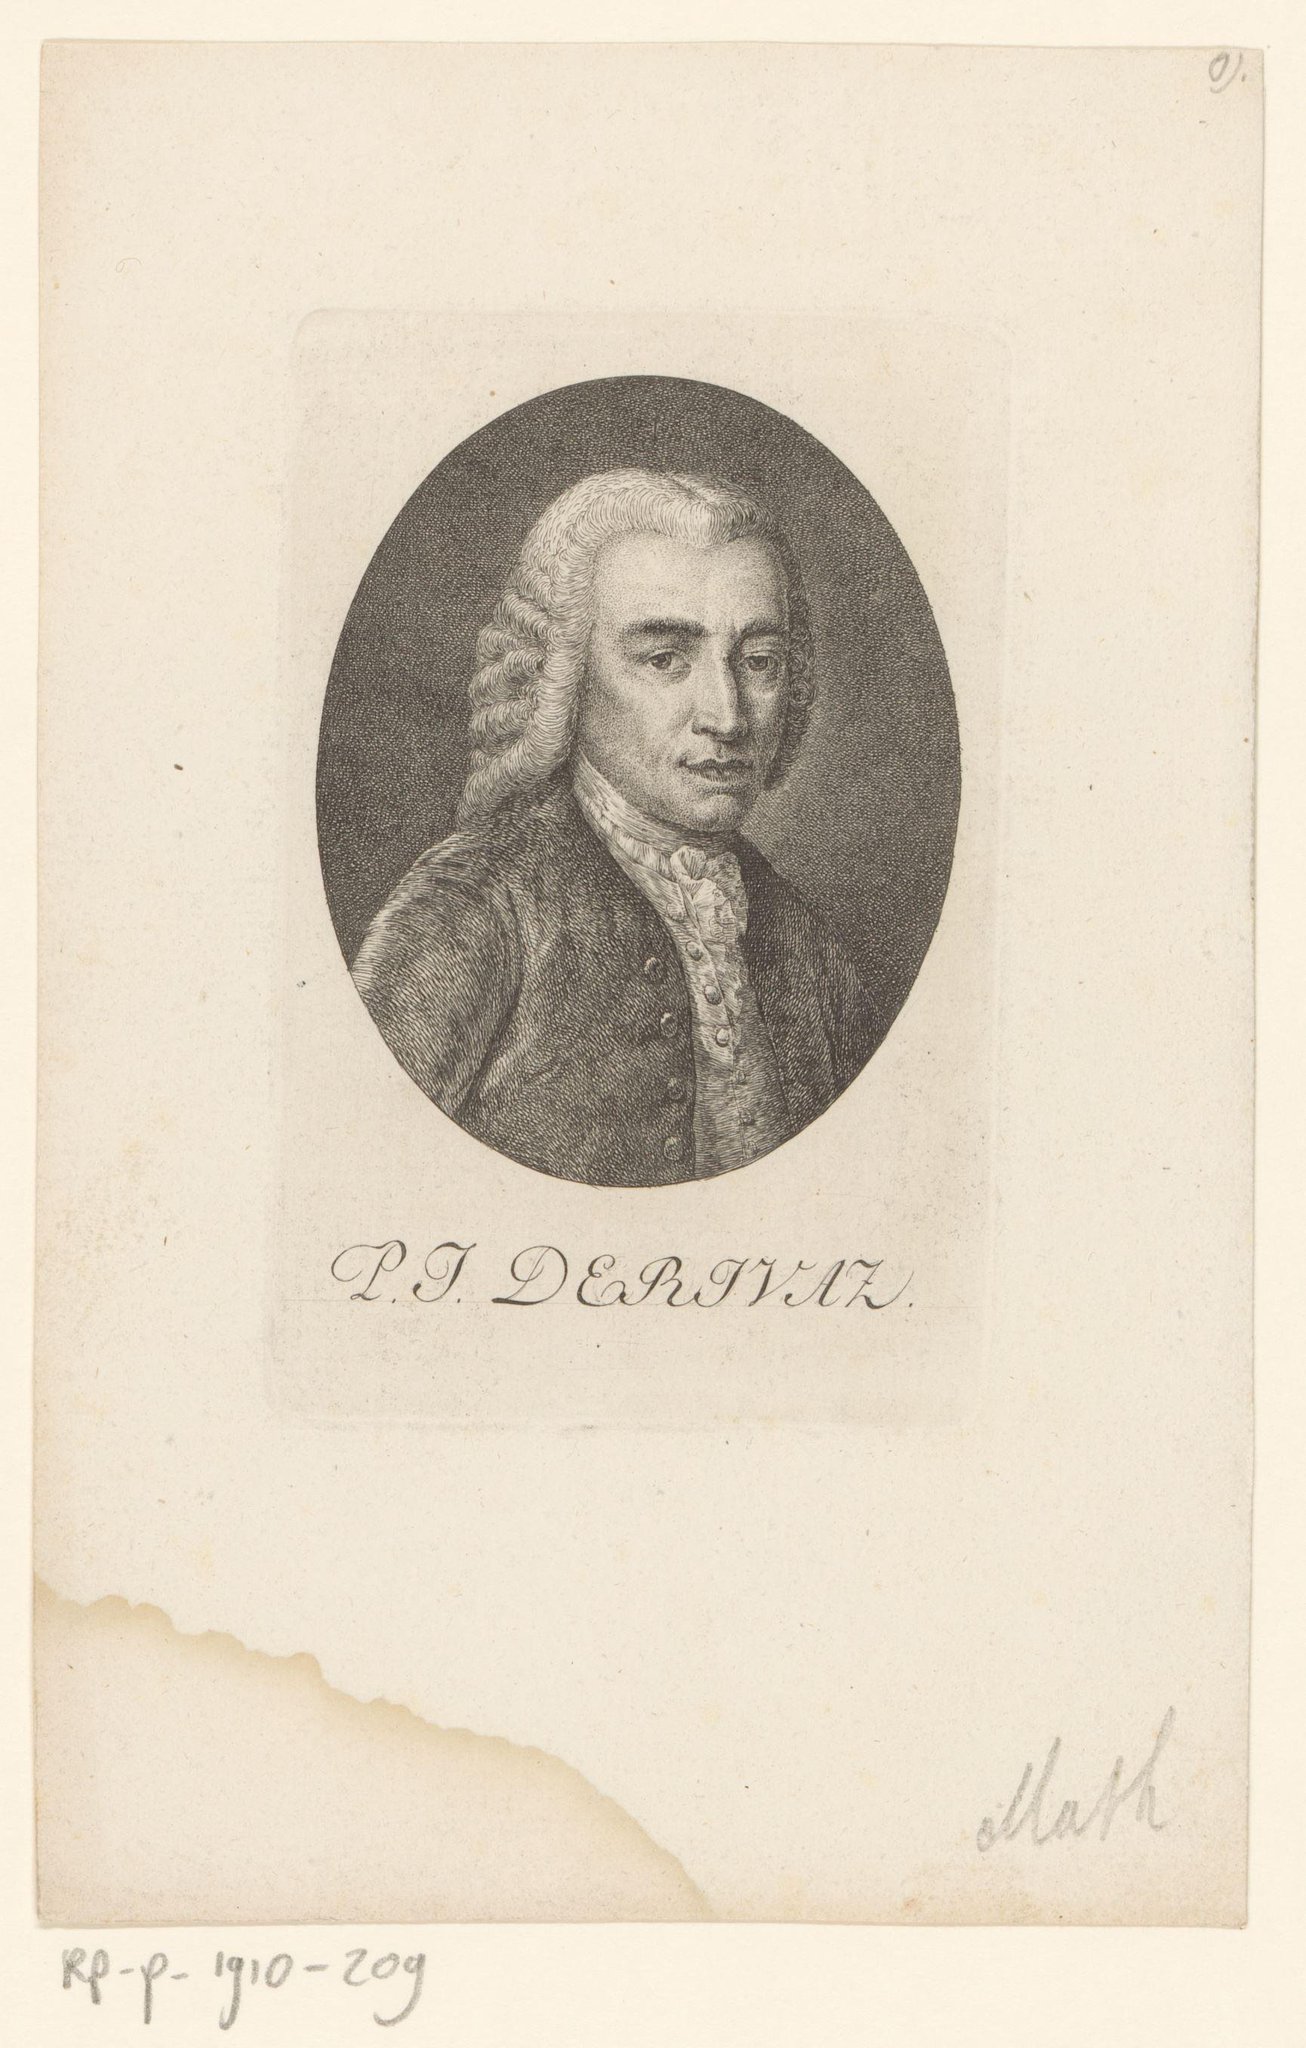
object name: print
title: Portret van Auguste Arthur de la Rive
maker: heinrich pfenninger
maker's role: print maker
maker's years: 1749-1815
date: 1759-1815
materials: paper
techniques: etching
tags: physicist, historical persons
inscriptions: collector's mark: Lugt 2228